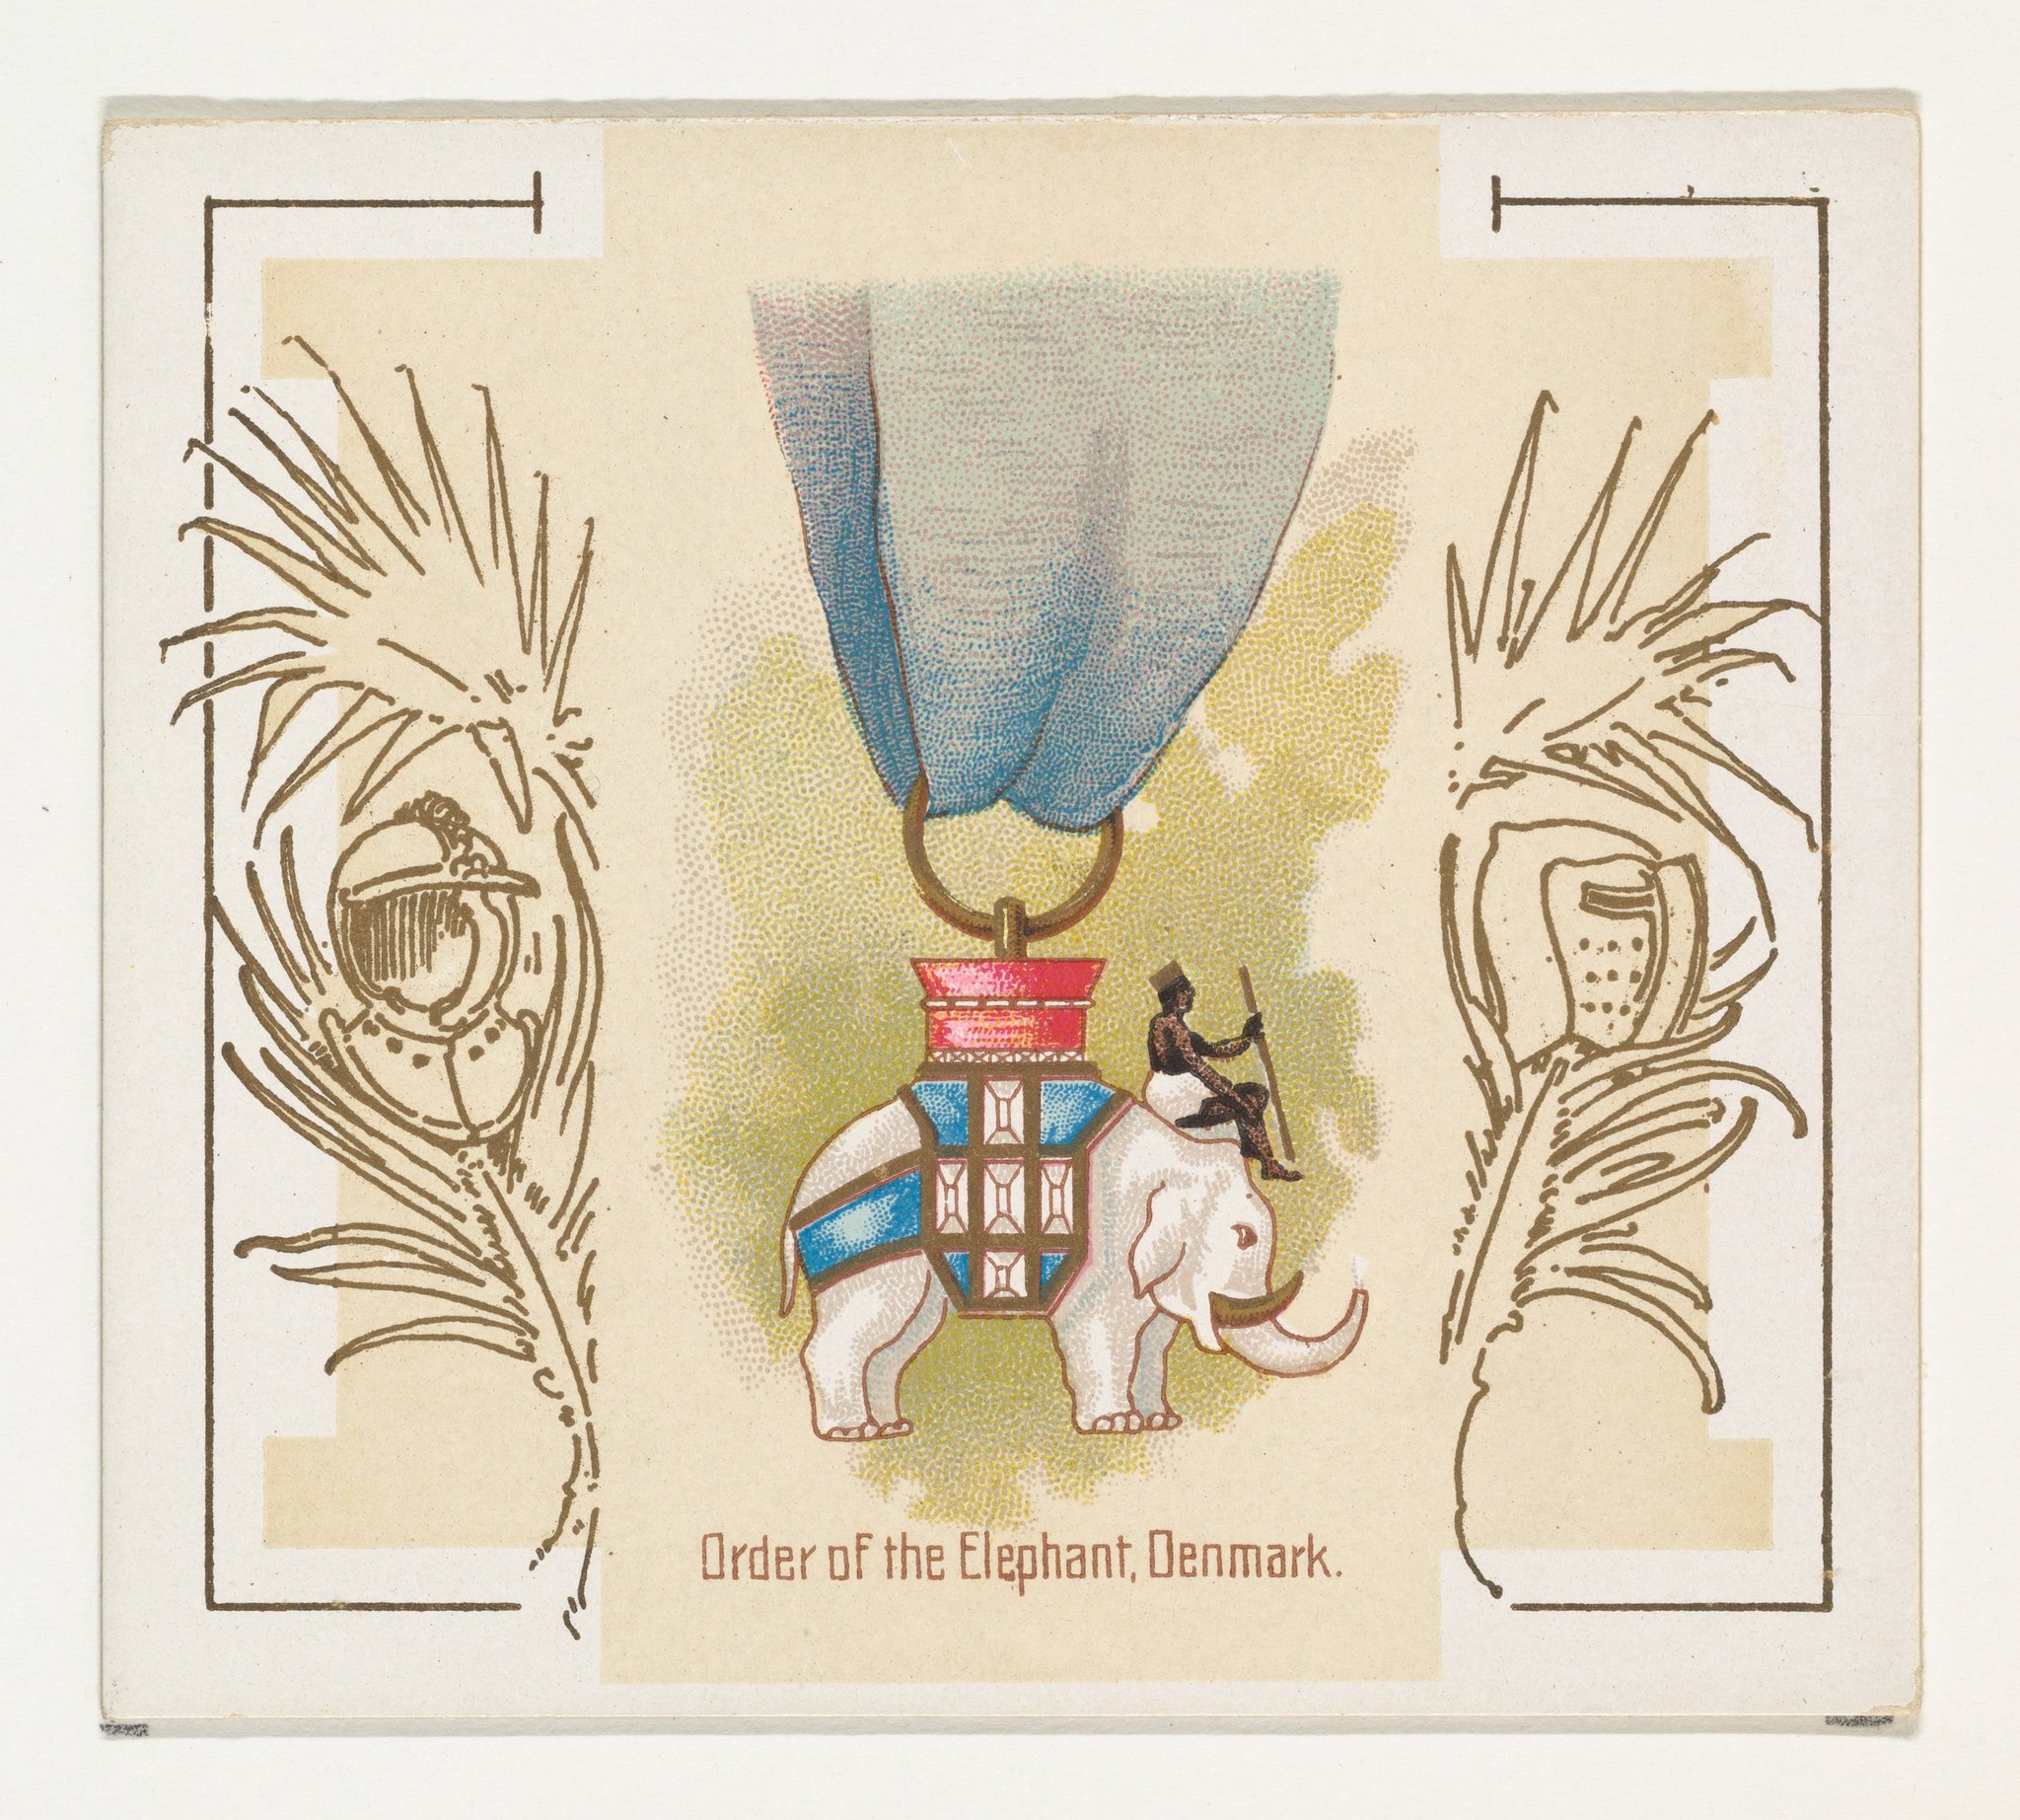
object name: print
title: Order of the Elephant, Denmark, from the World's Decorations series (N44) for Allen & Ginter Cigarettes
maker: allen & ginter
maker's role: publisher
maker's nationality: american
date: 1890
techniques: color lithograph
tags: elephants,medals